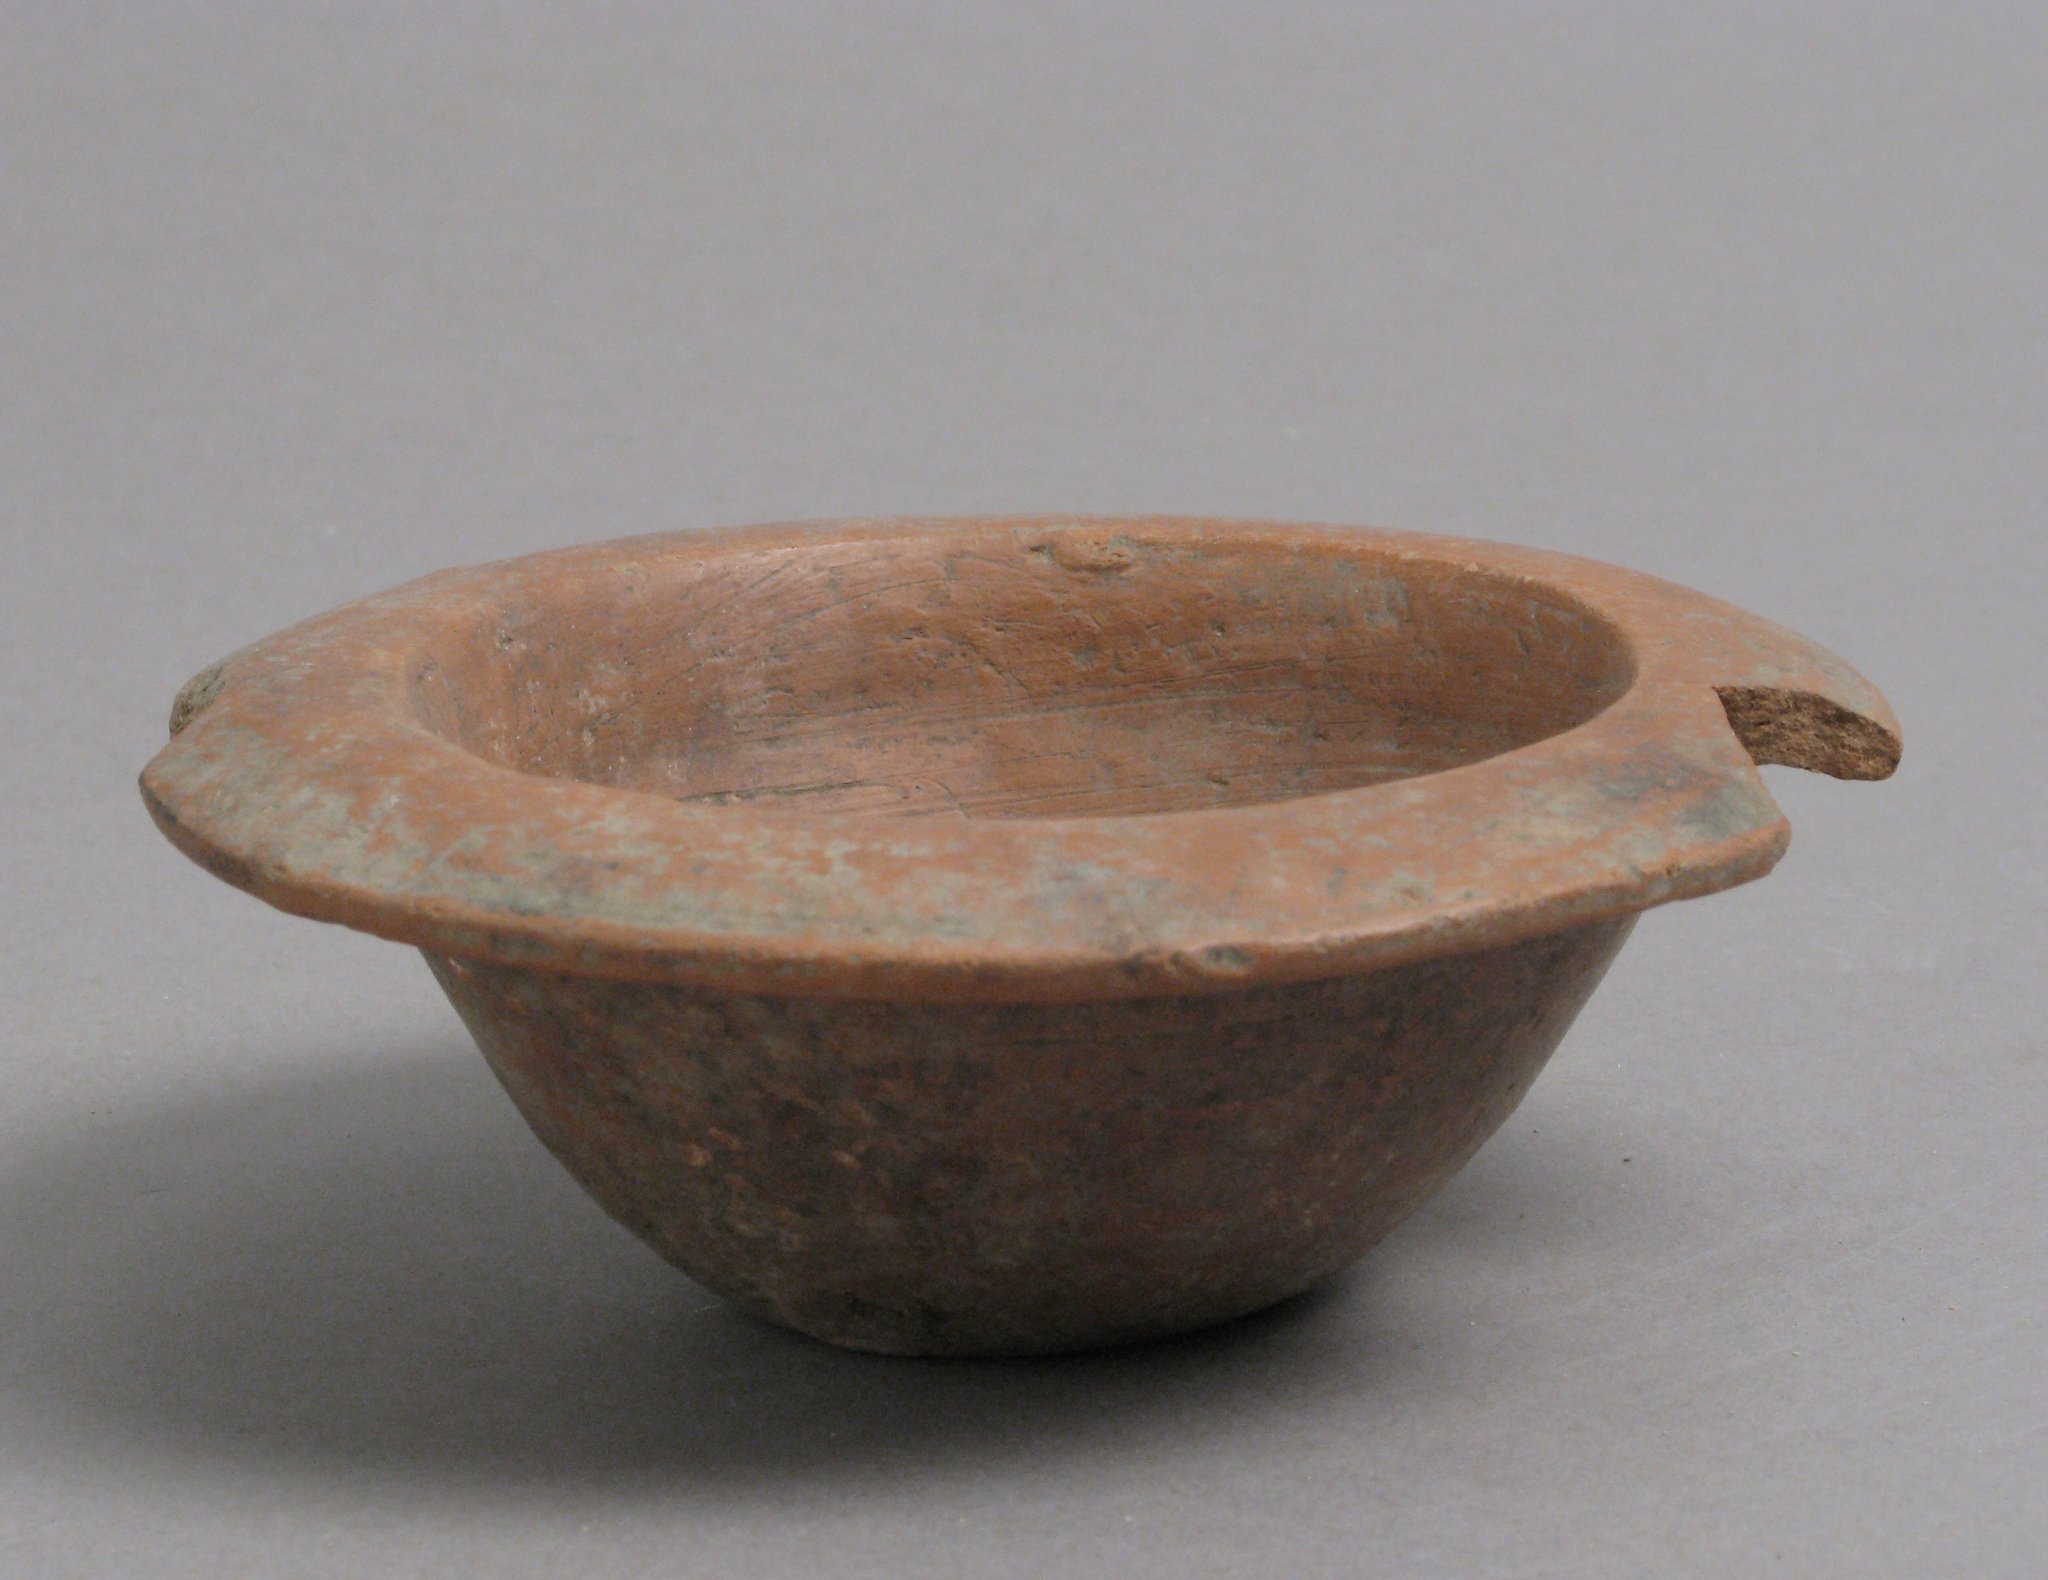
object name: bowl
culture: coptic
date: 301-700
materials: earthenware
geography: egypt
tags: bowls